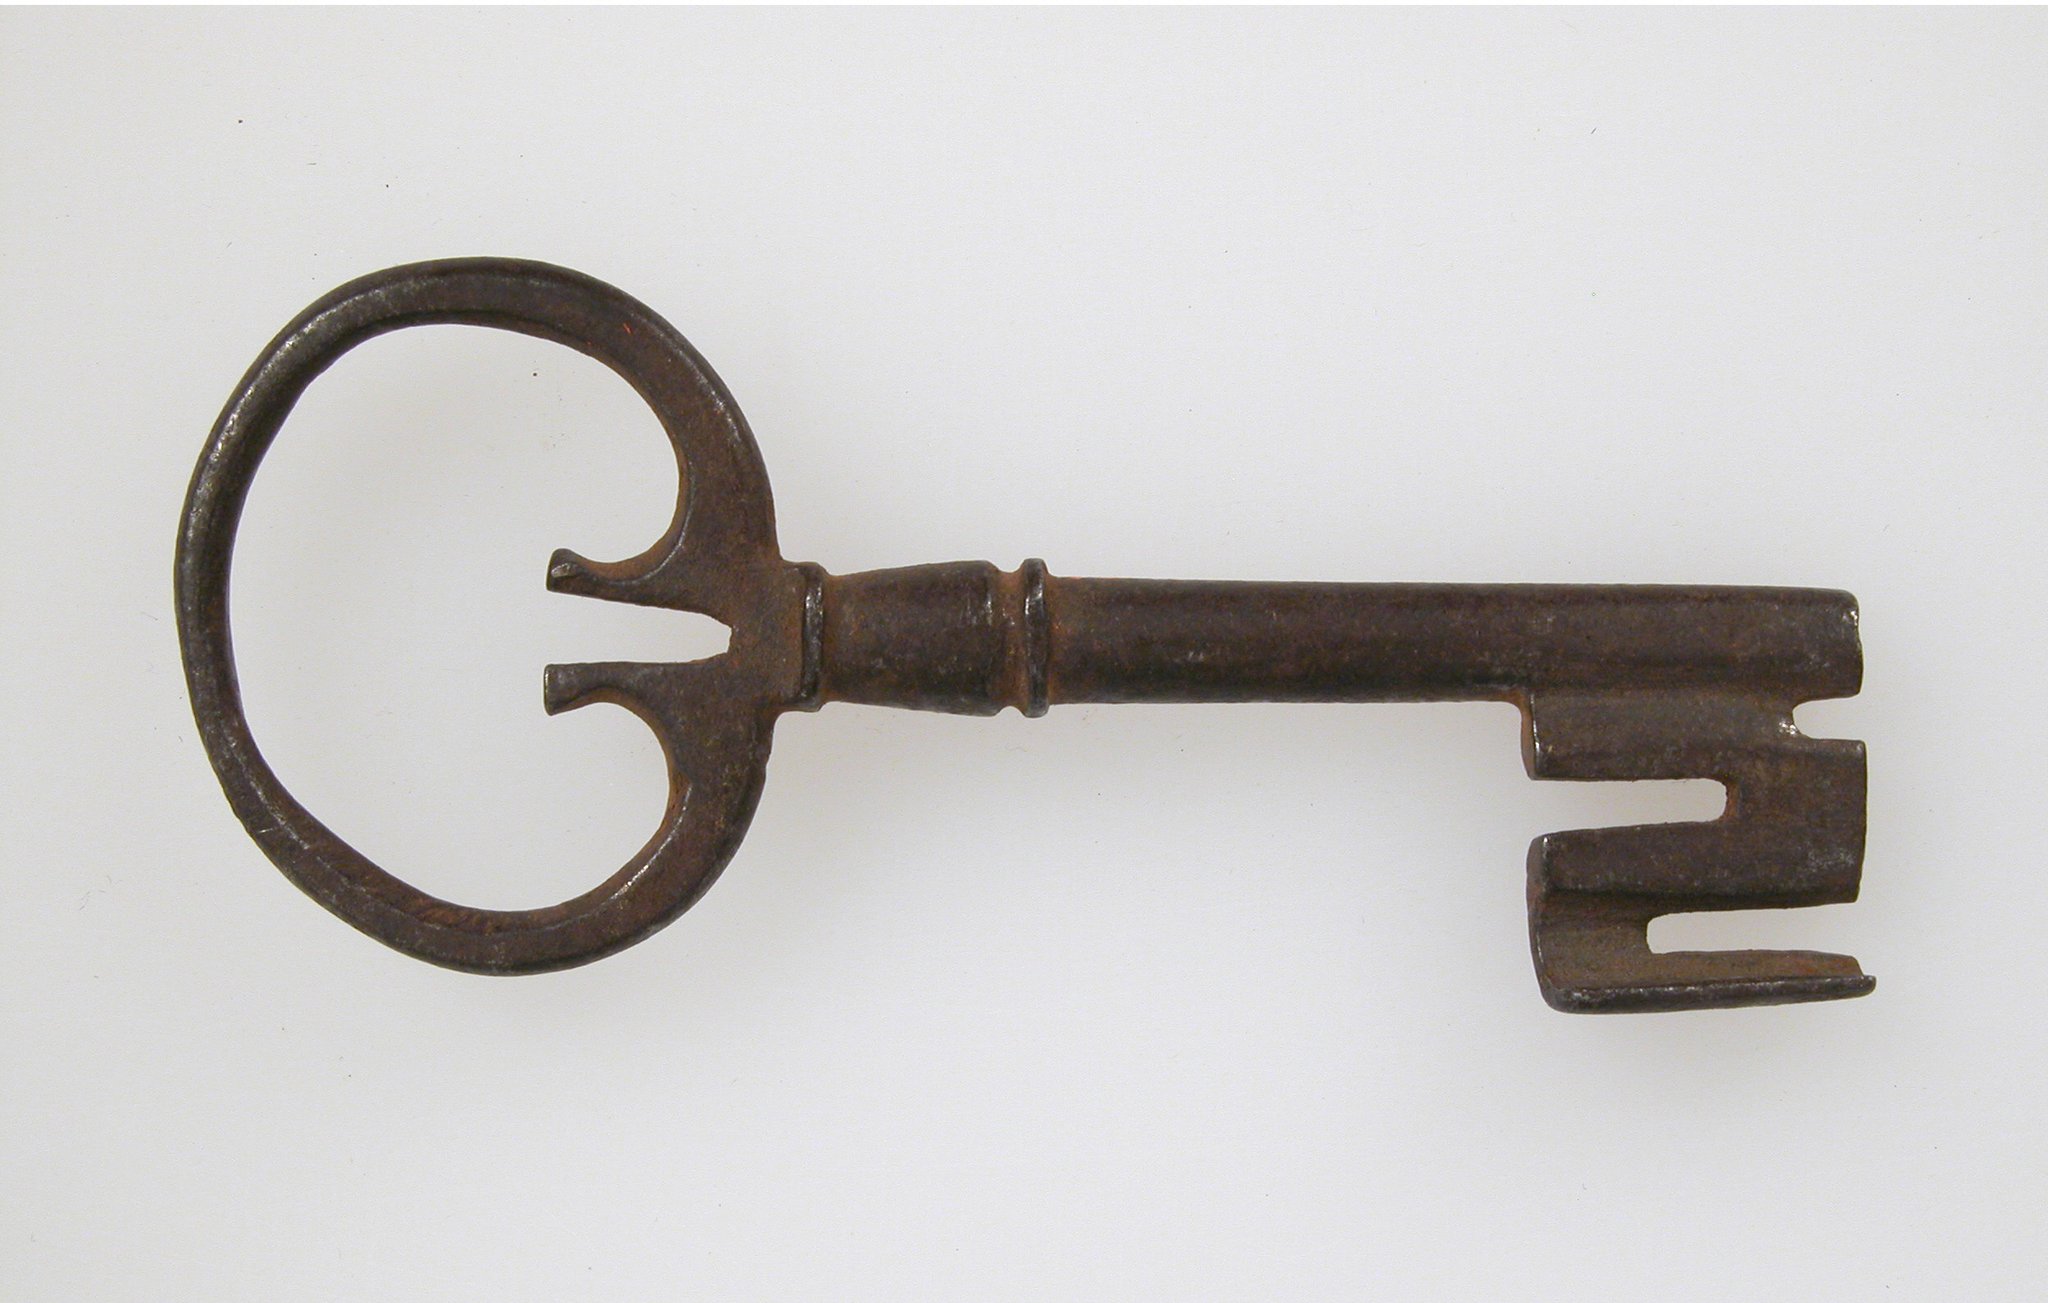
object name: key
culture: german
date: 1501-1600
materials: iron